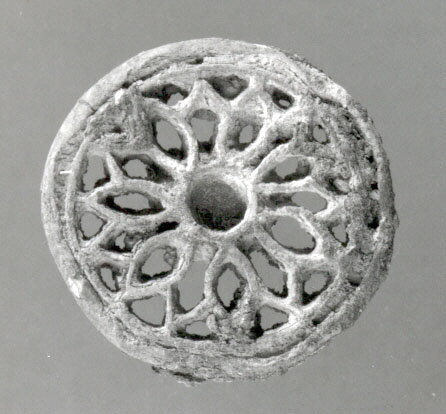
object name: stamp seal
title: Compartmented stamp seal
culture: bactria-margiana archaeological complex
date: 2333-1668 BCE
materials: copper alloy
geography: bactria-margiana